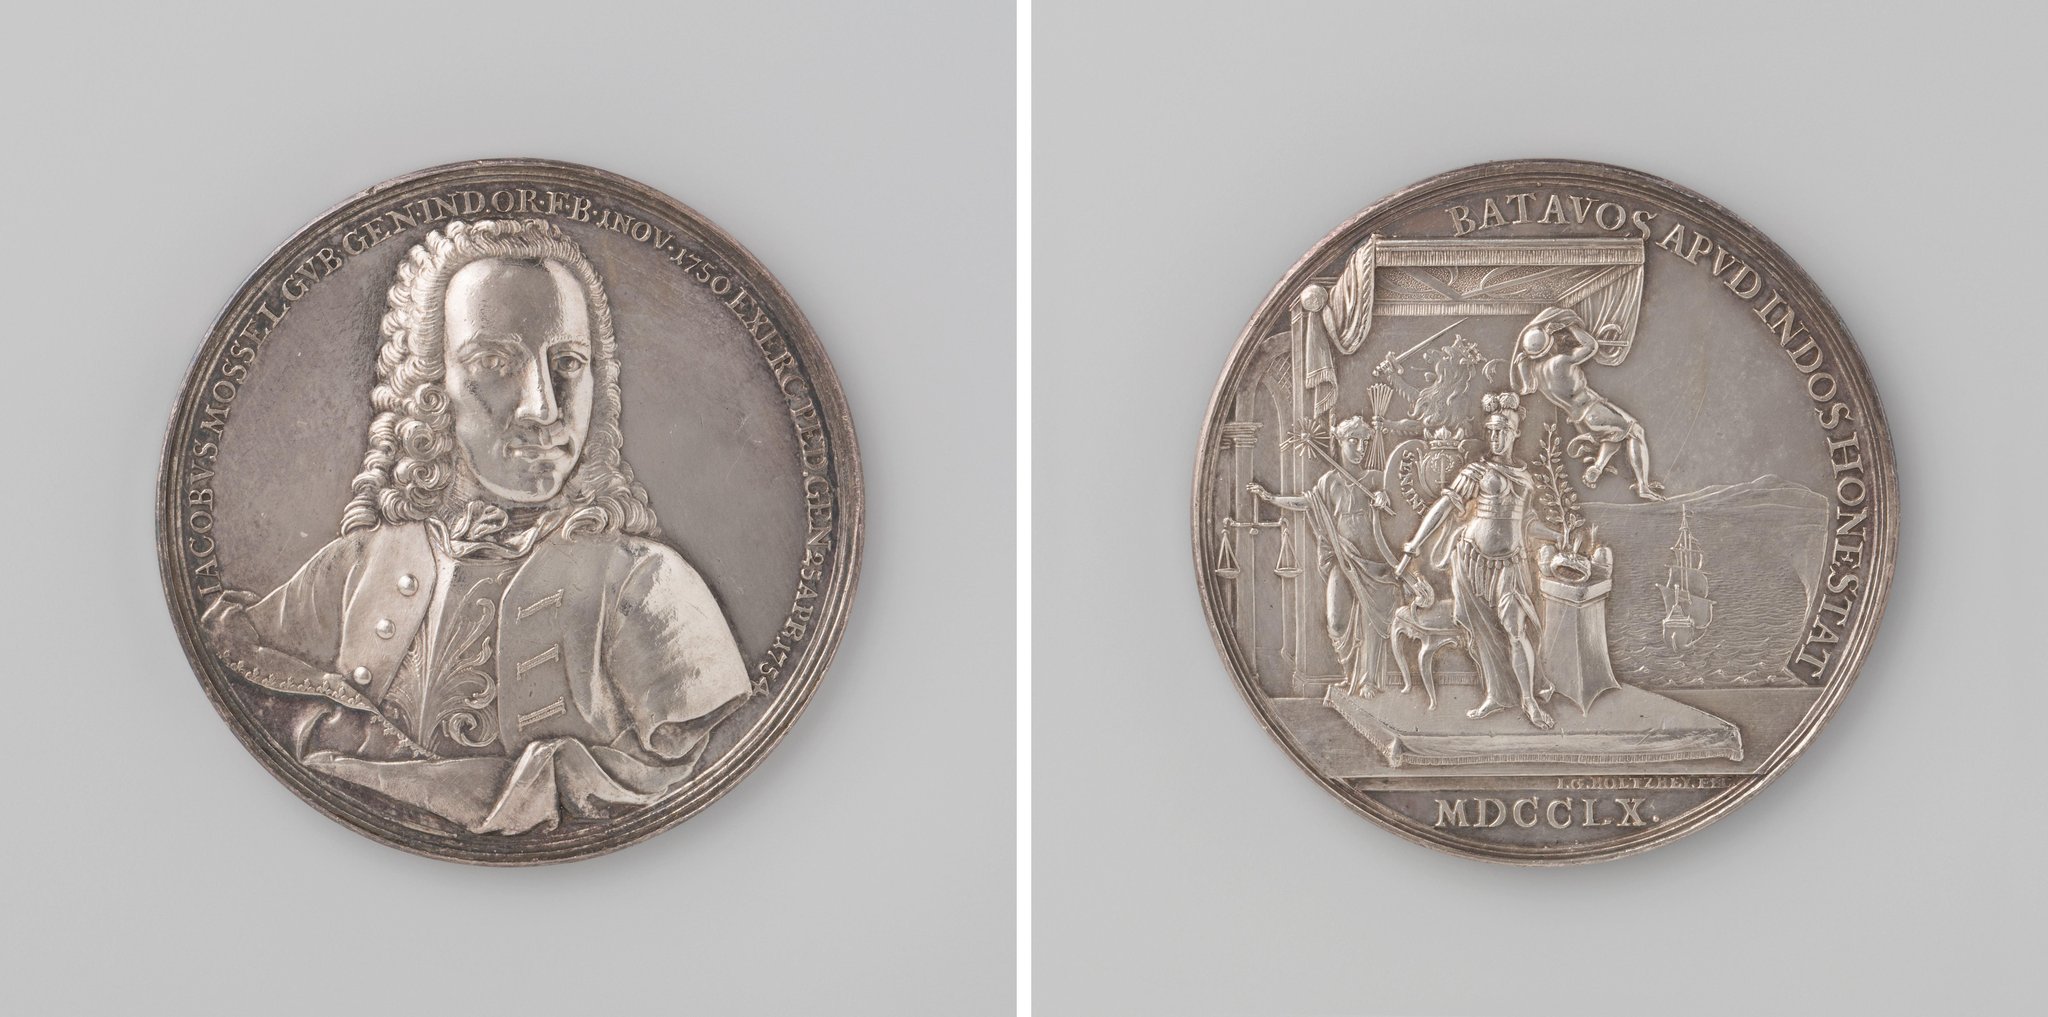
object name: medal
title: Jacob Mossel (1704-1761), gouverneur-generaal van Nederlands-Indië (1750-1761)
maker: johan george holtzhey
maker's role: mintmaster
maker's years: 1726-1808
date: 1760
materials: silver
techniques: striking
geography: amsterdam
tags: enkhuizen, batavia, dutch east indies, the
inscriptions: circumscription: ‘Batavos apud Indos Honestat’, date: ‘MDCCLX’, circumscription: ‘Jacobus Mossel Gvb.Gen.Ind.Or. F.B. 1 Nov 1750 Exerc.Ped.Gen. 25 Apr 1754’, signature: ‘I.G. Holtzhey fec’